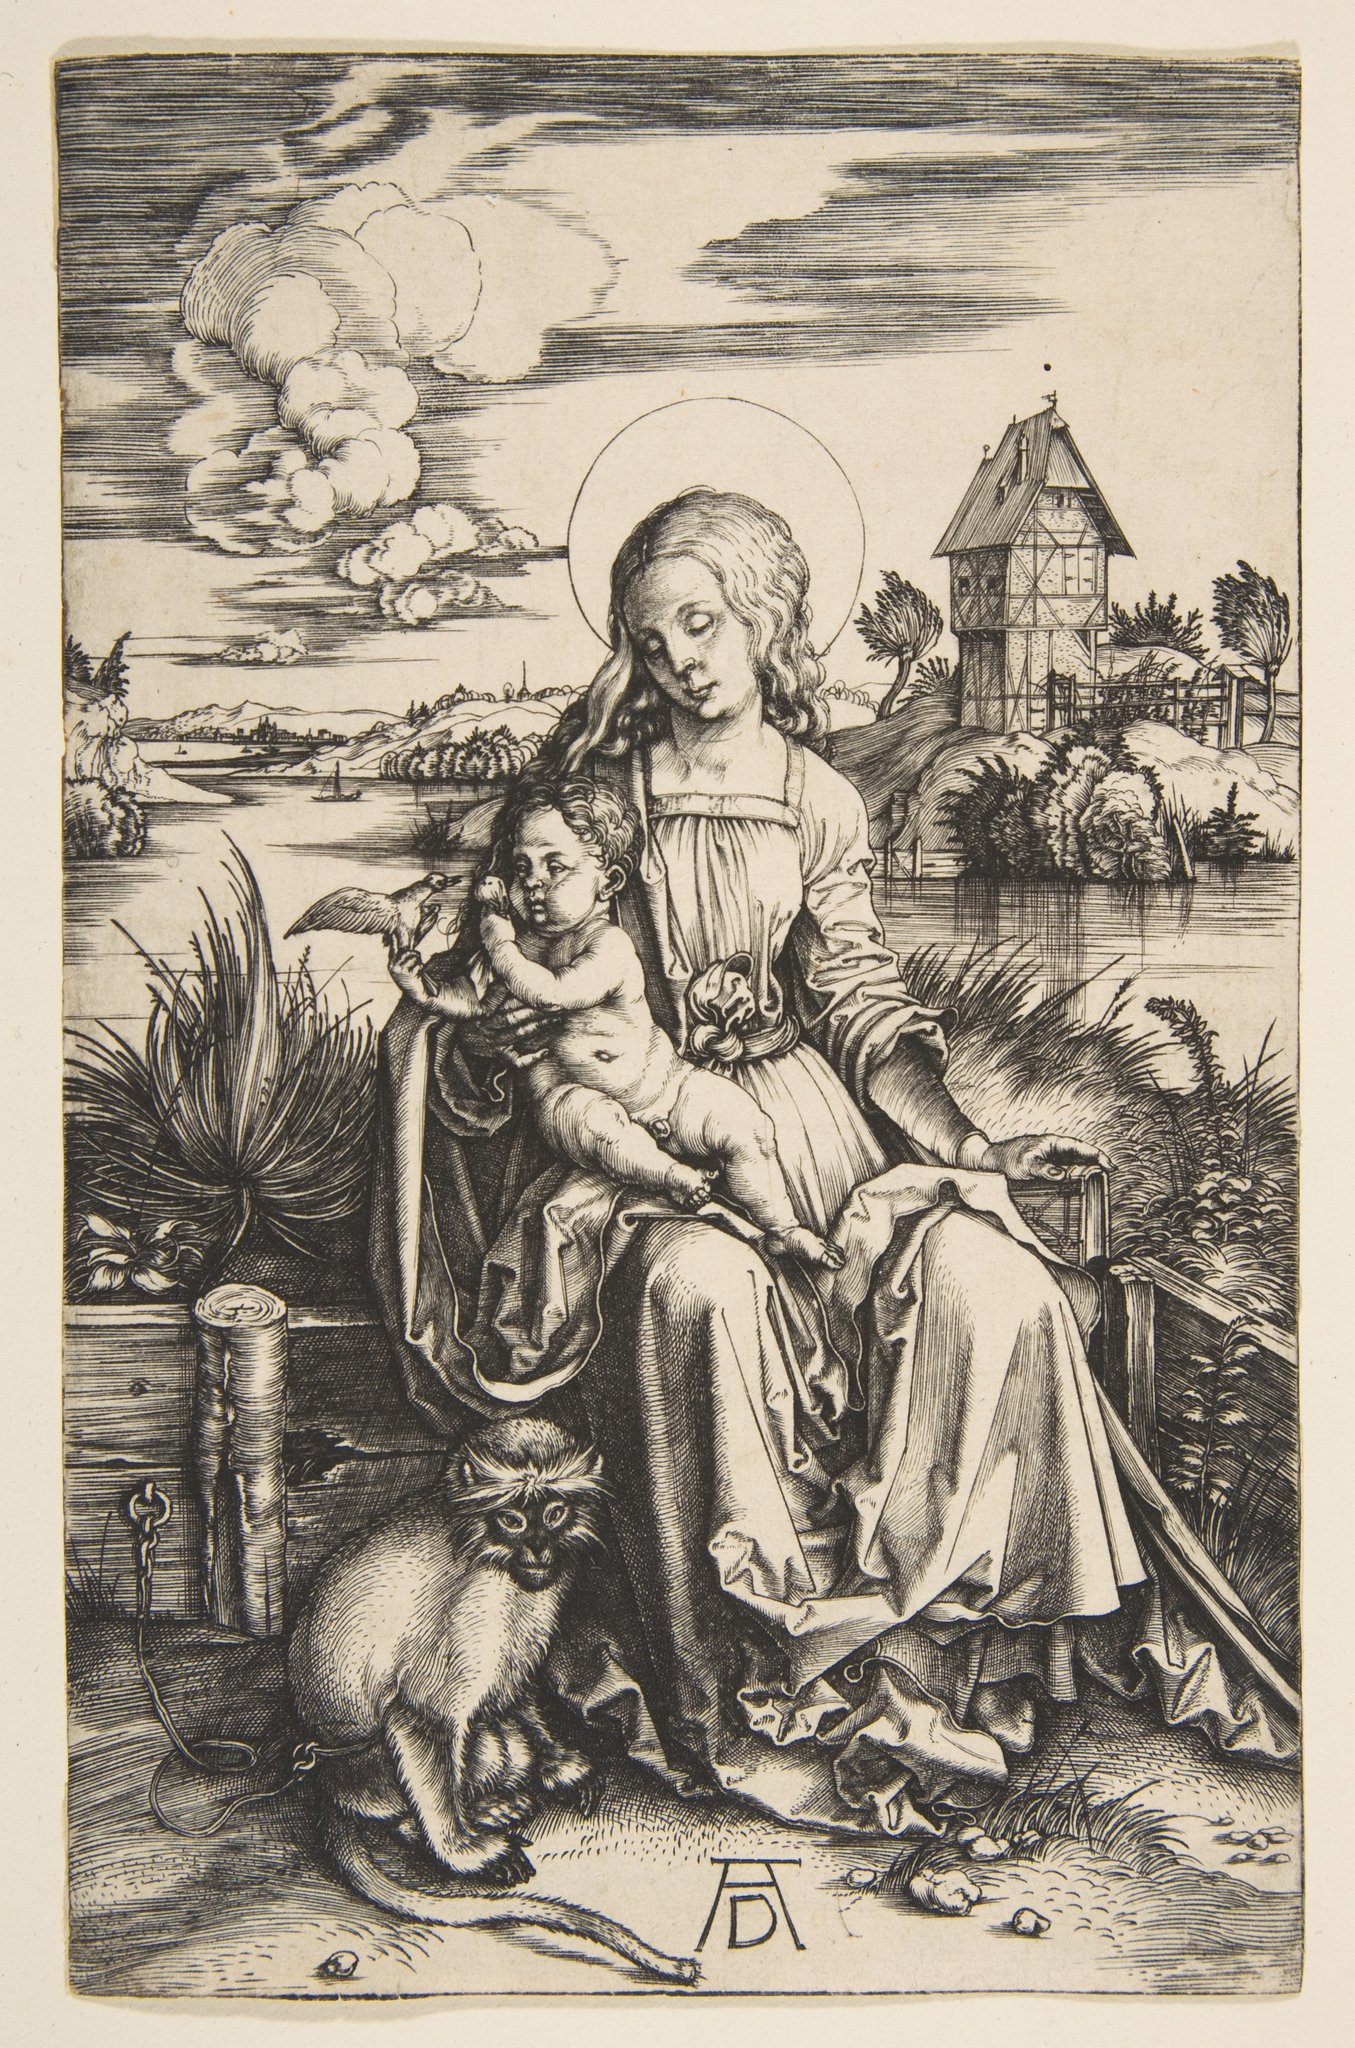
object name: print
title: Virgin and Child with the Monkey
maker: albrecht dürer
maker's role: artist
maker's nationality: german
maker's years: 1471-1528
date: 1498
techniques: engraving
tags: birds,monkeys,madonna and child